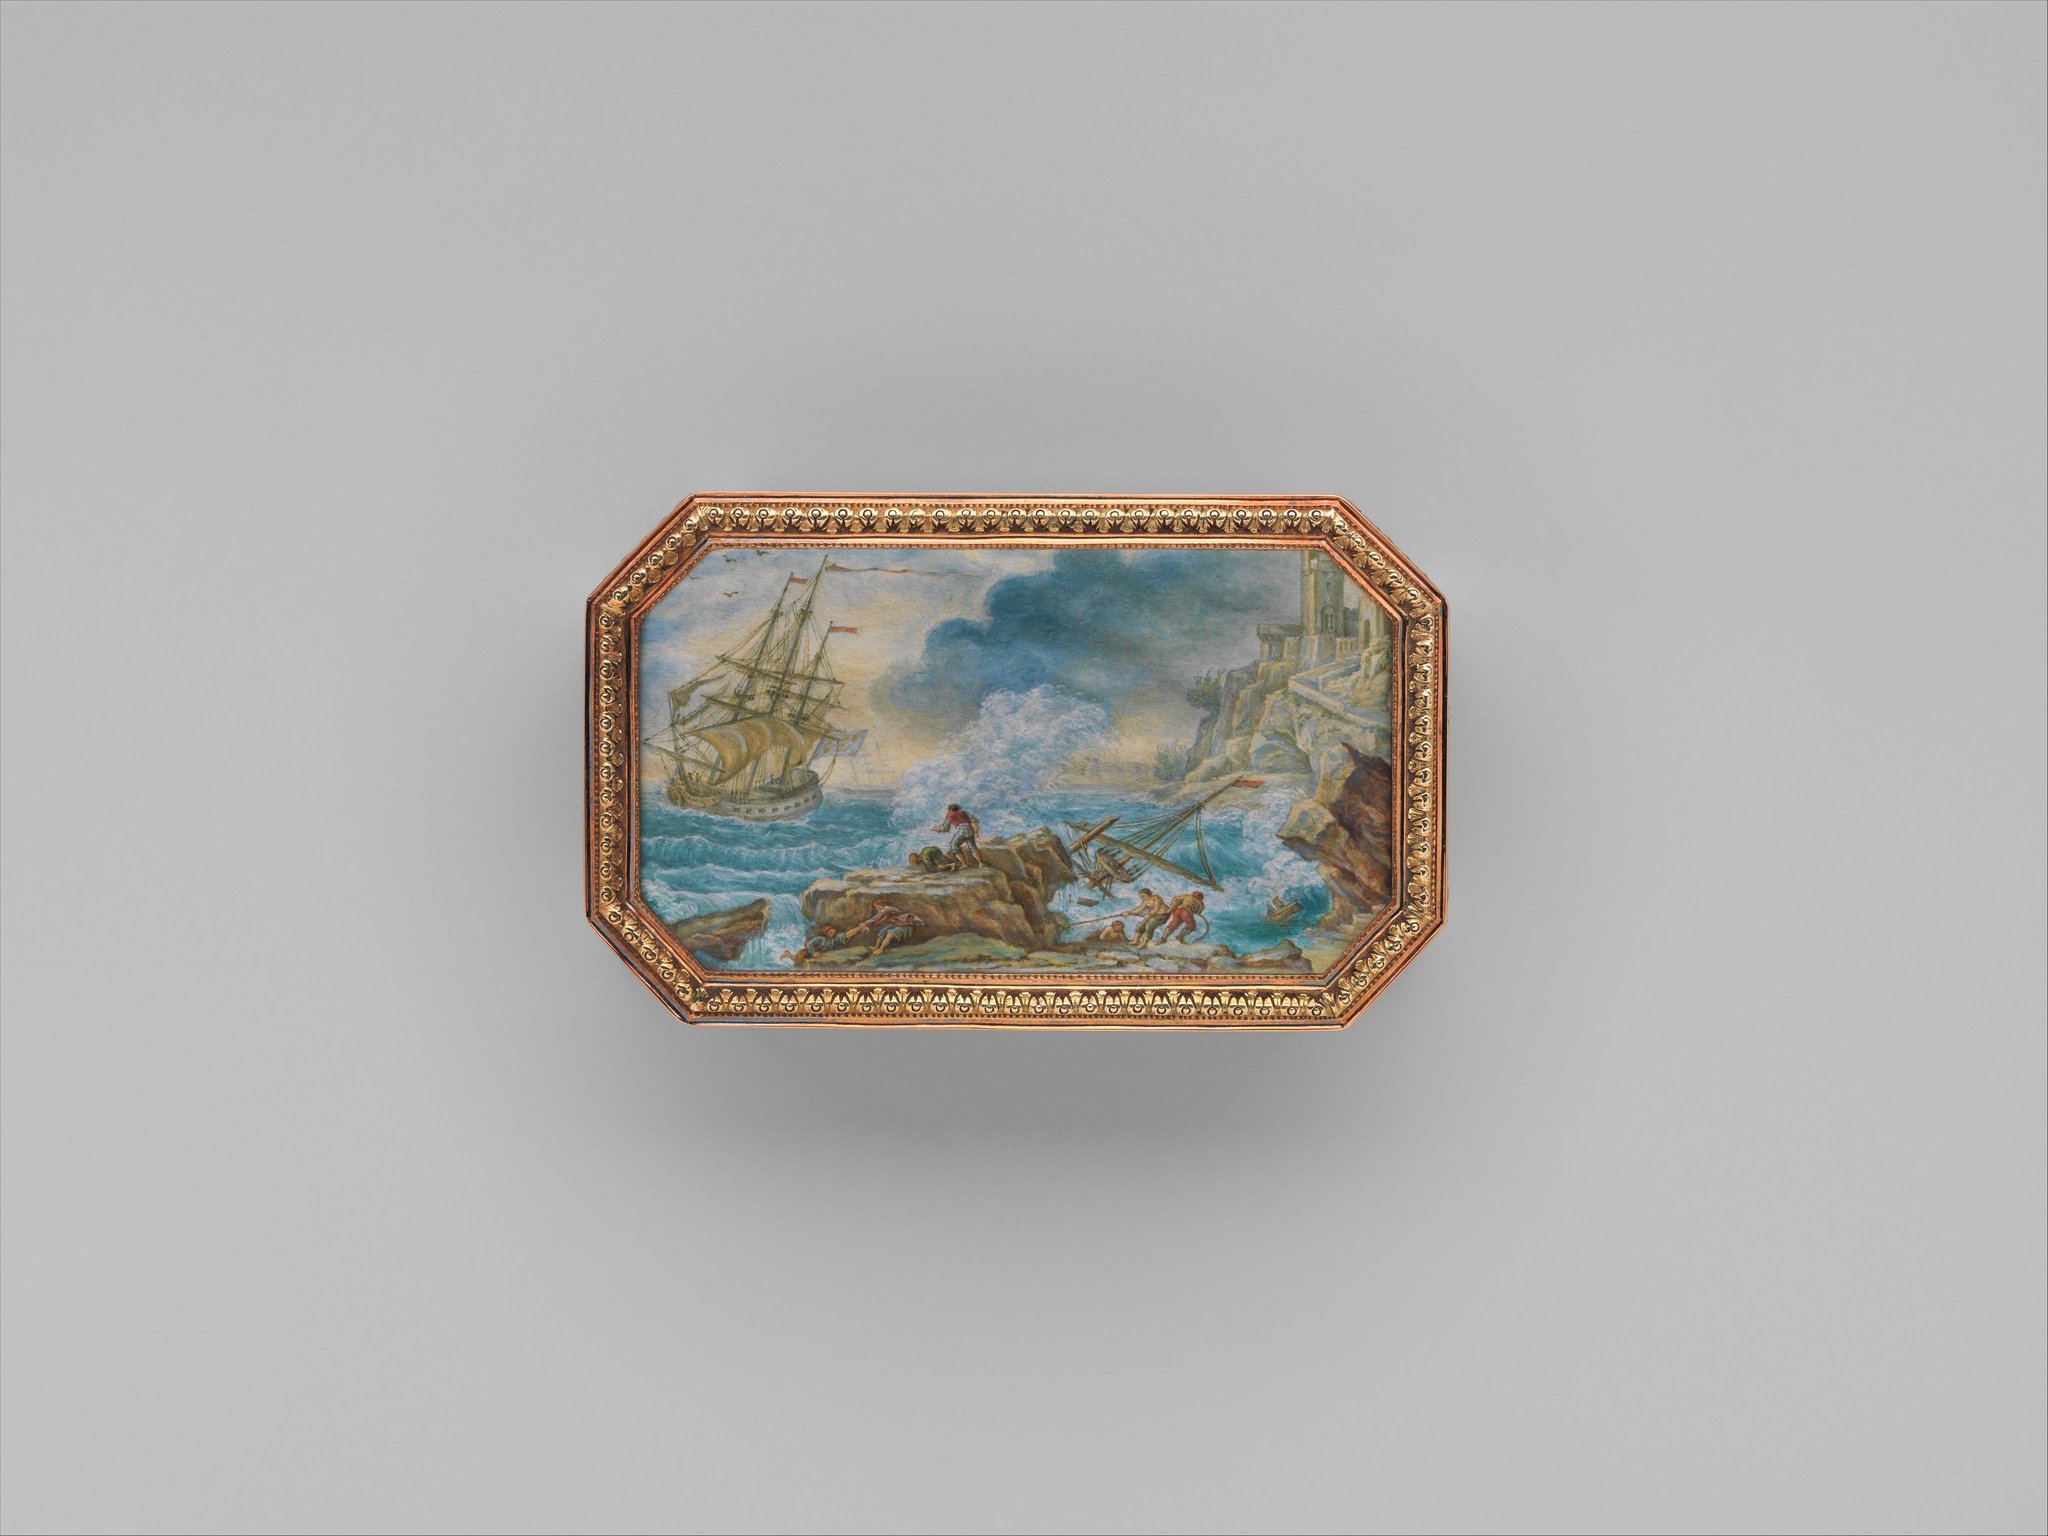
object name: snuffbox, painting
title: Snuffbox with six maritime scenes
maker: dominique-françois poitreau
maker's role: maker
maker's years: 1711-1811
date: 1770-1771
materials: gold, paper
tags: human figures,boats